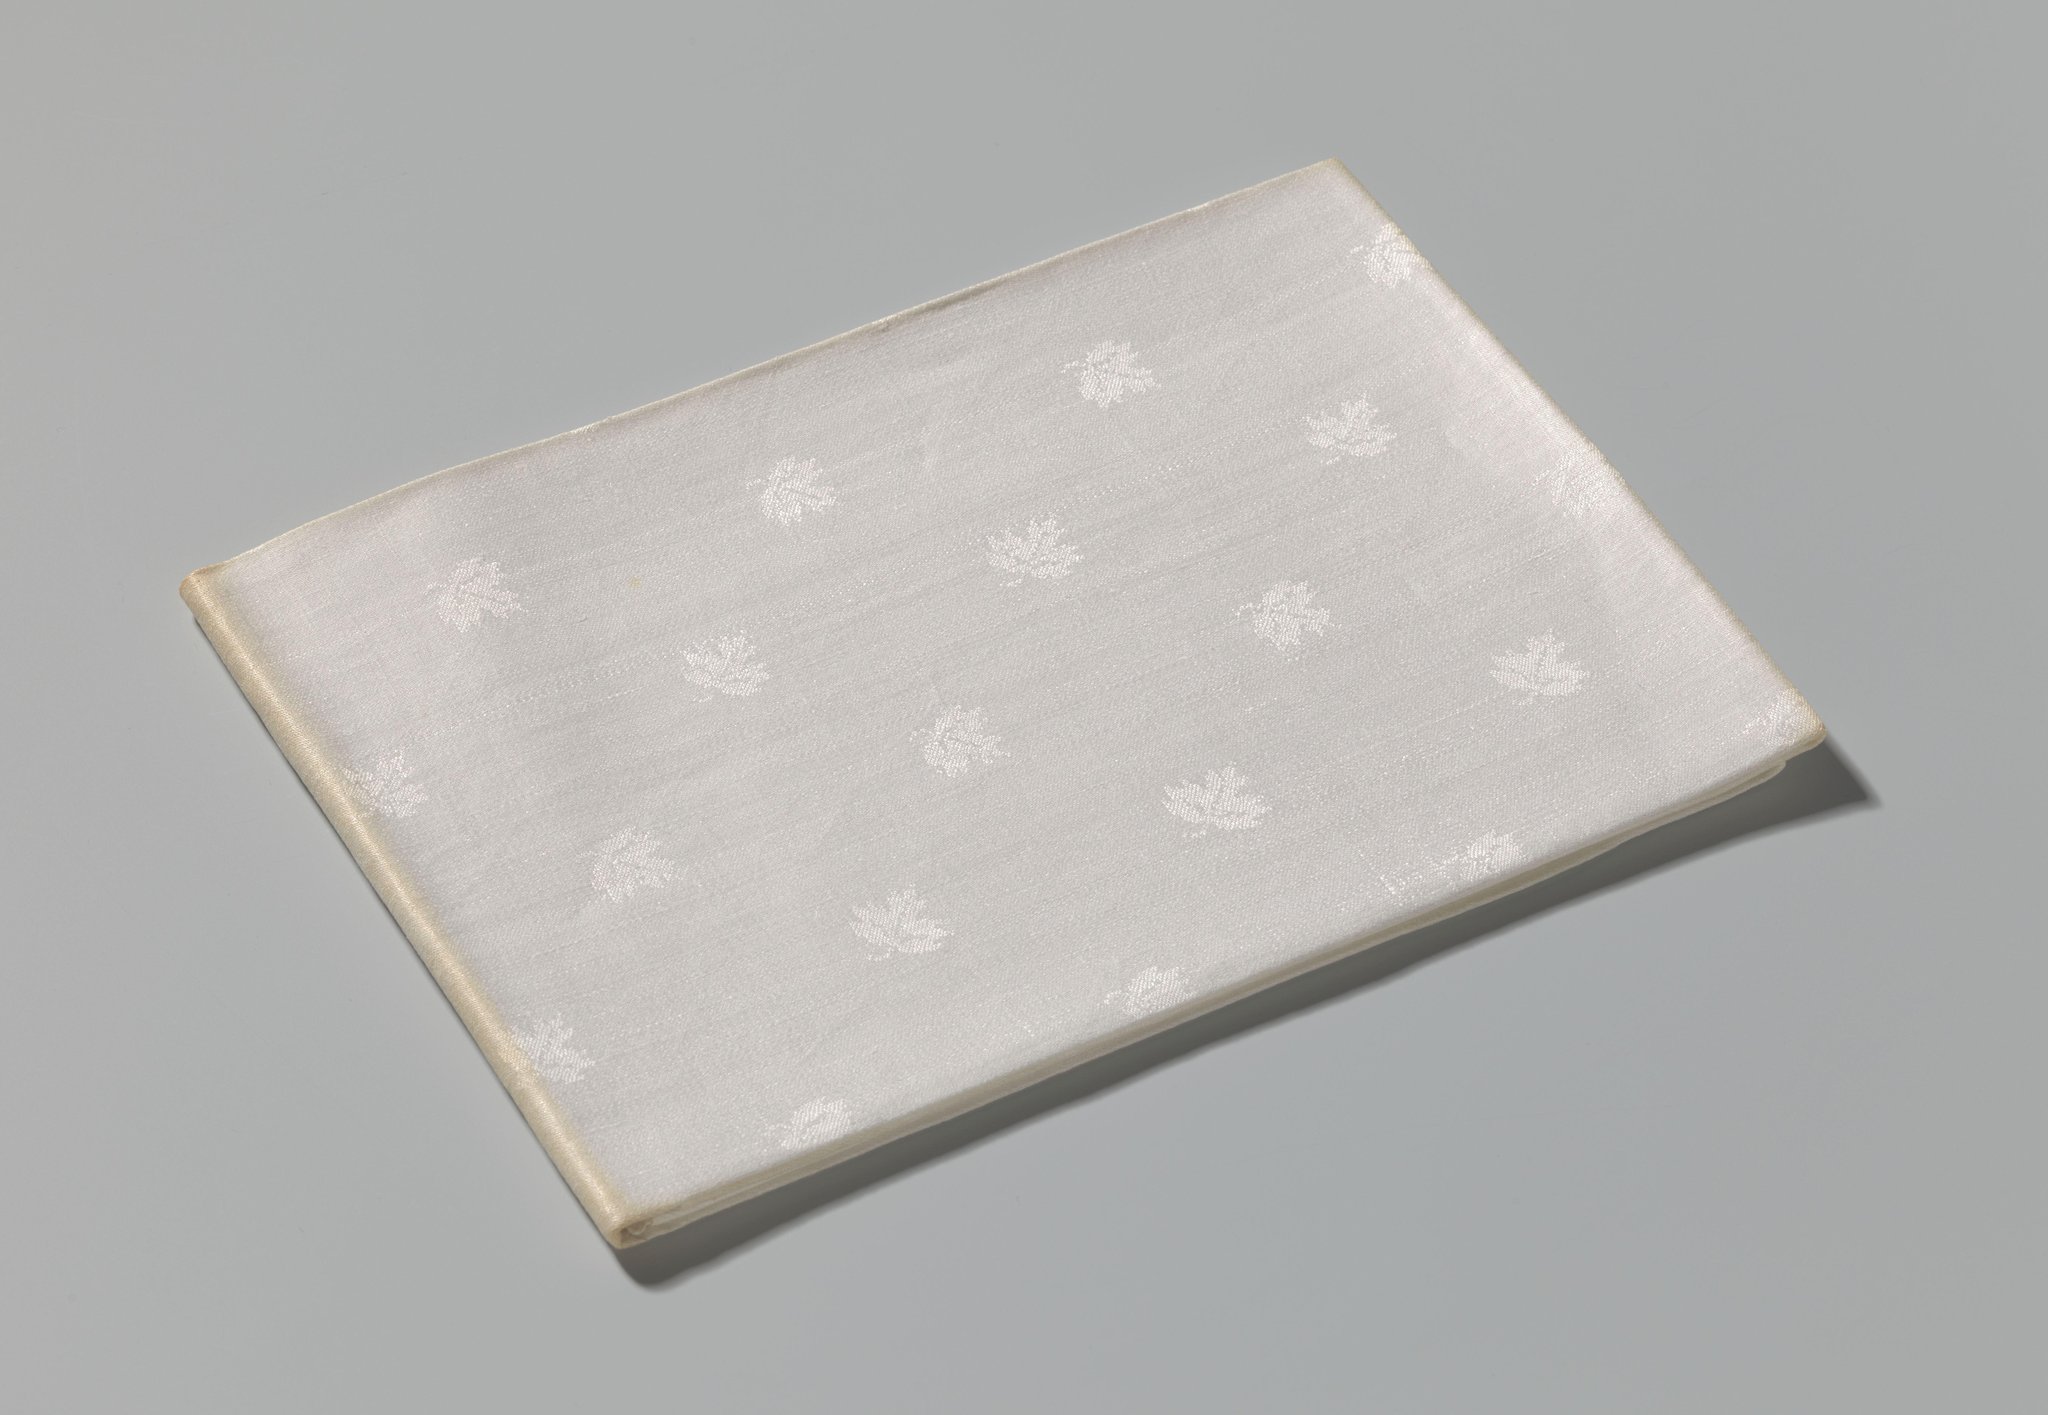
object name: napkin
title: Servet van wit linnendamast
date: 1800-1900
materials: linen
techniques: damask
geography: netherlands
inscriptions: mark: ‘twee palmtakken, waarbinnen de gekroonde initialen CB en 25’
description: Wit linnen damasten servet. Merk twee palmtakken, waarbinnen de gekroonde initialen CB en 25.